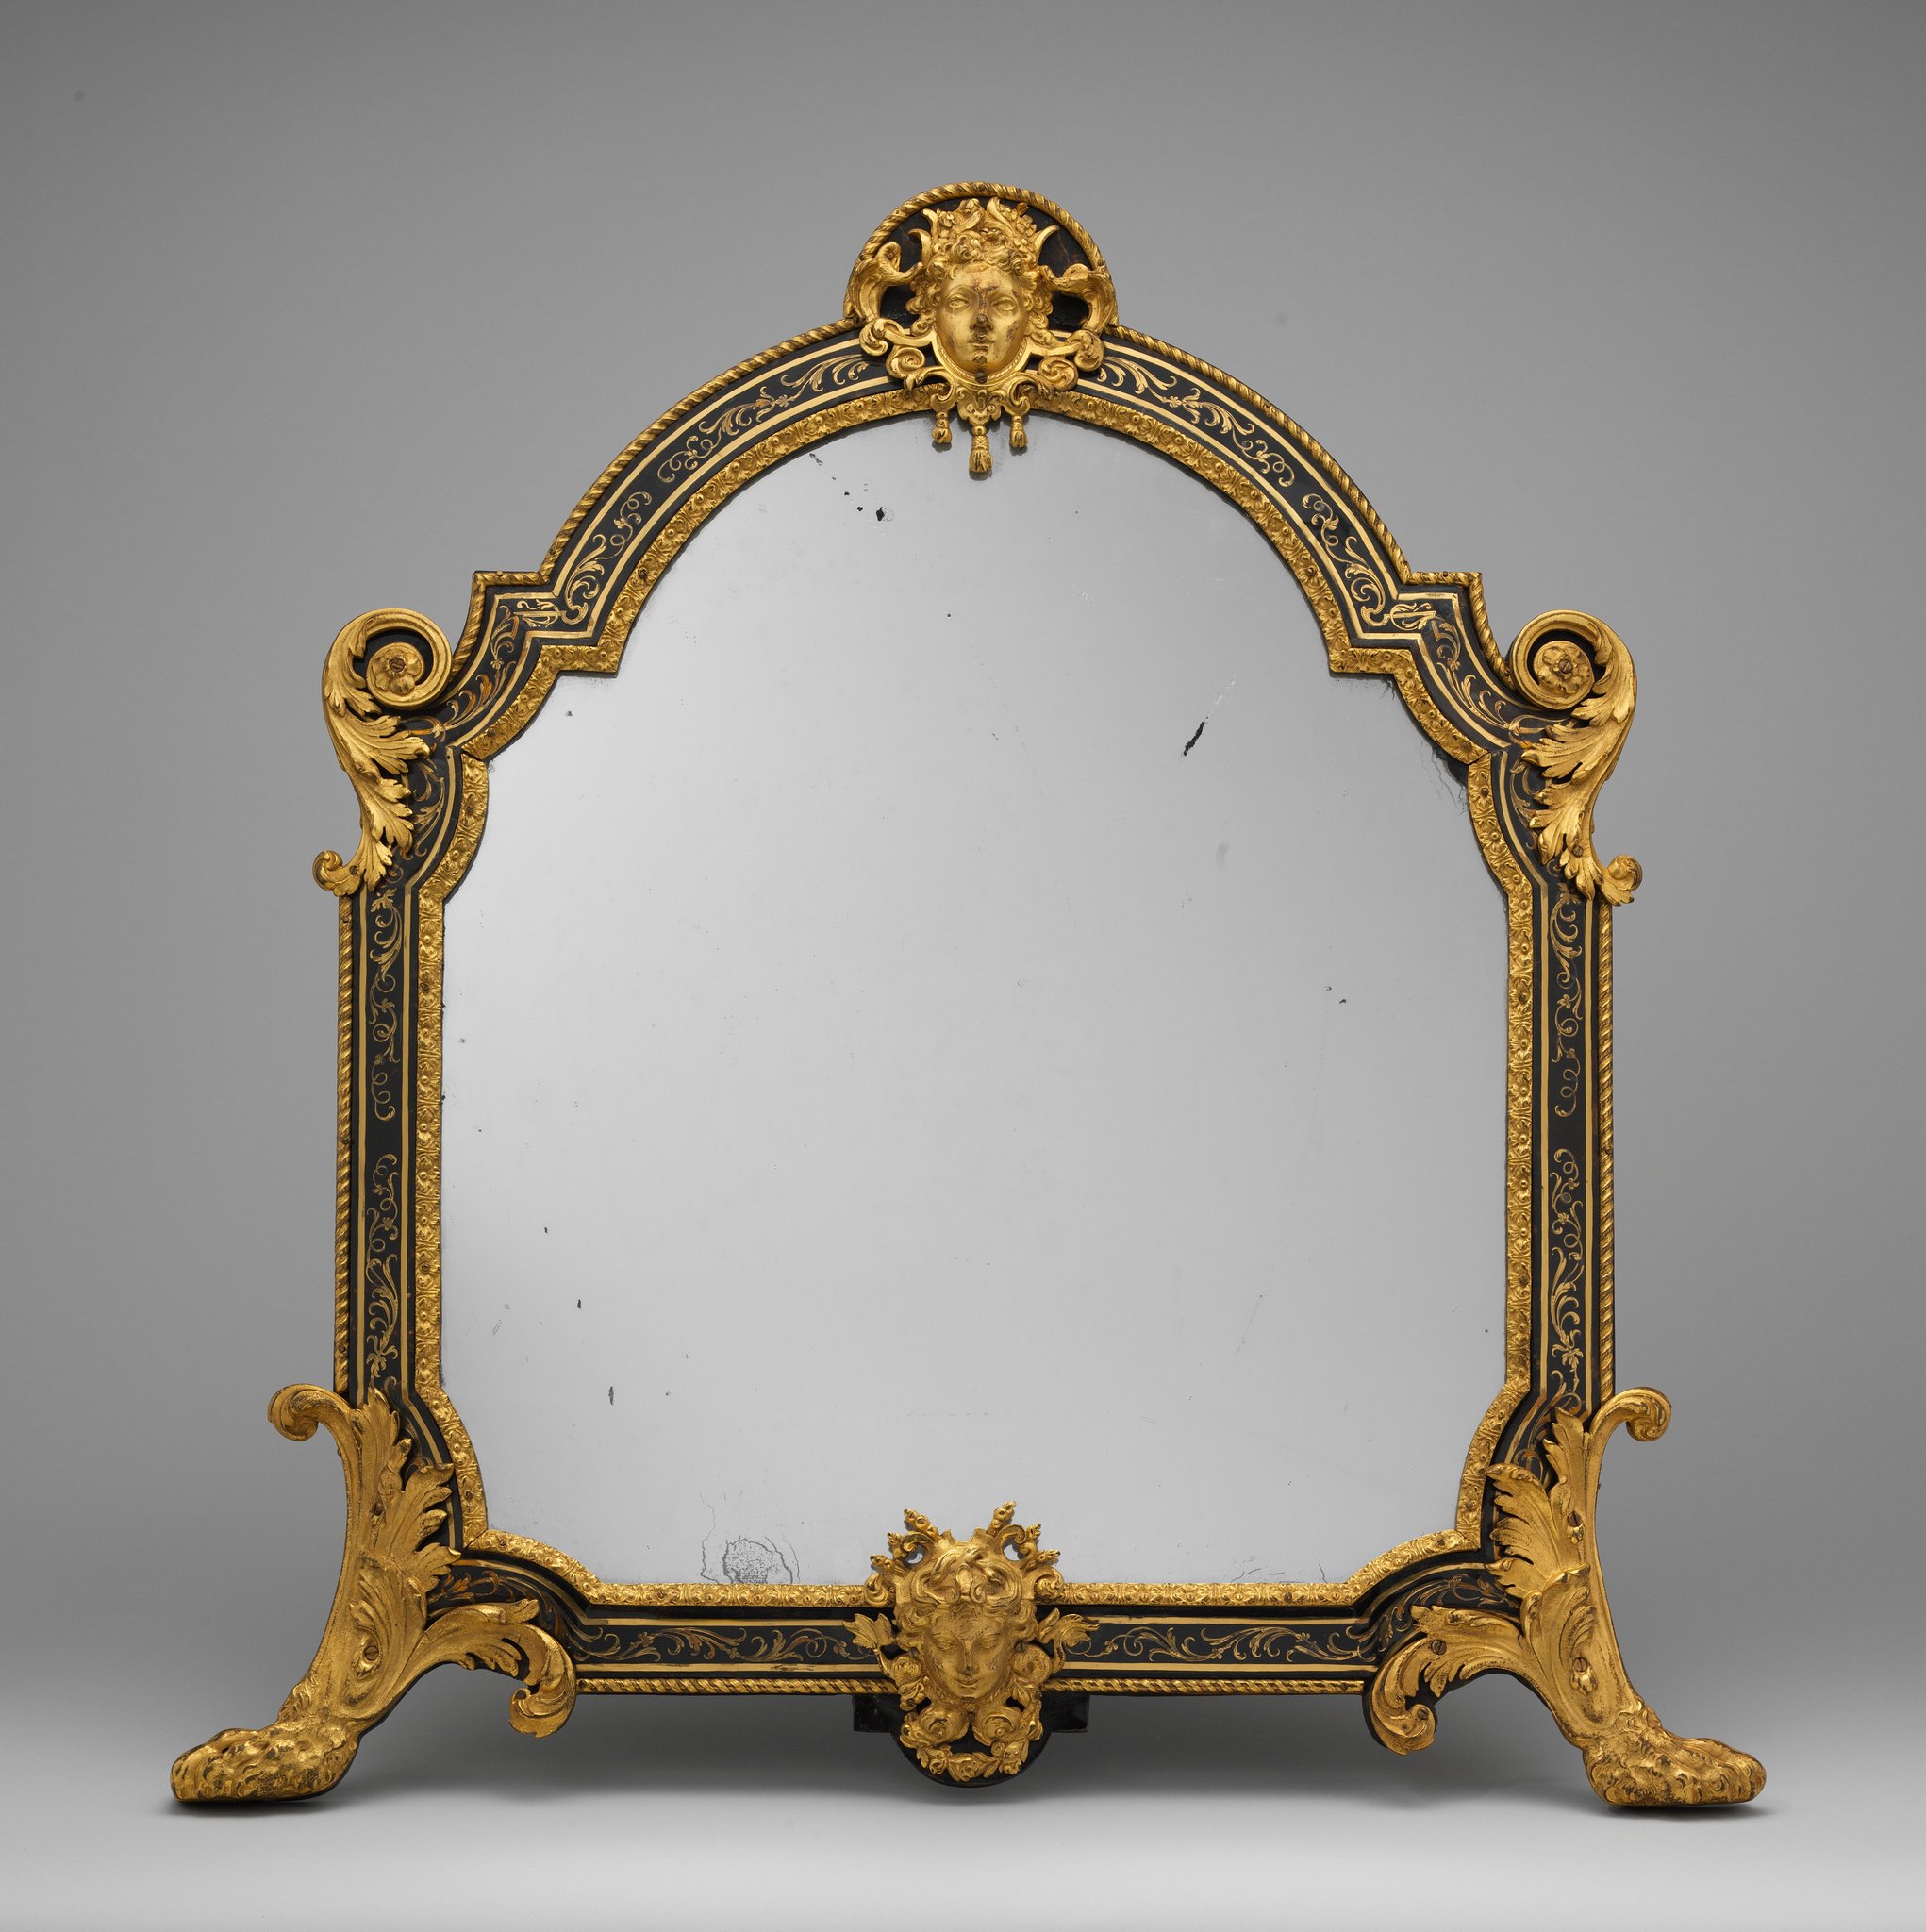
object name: dressing table mirror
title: Dressing-table mirror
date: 1700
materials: brass, wood, glass, shell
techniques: engraving